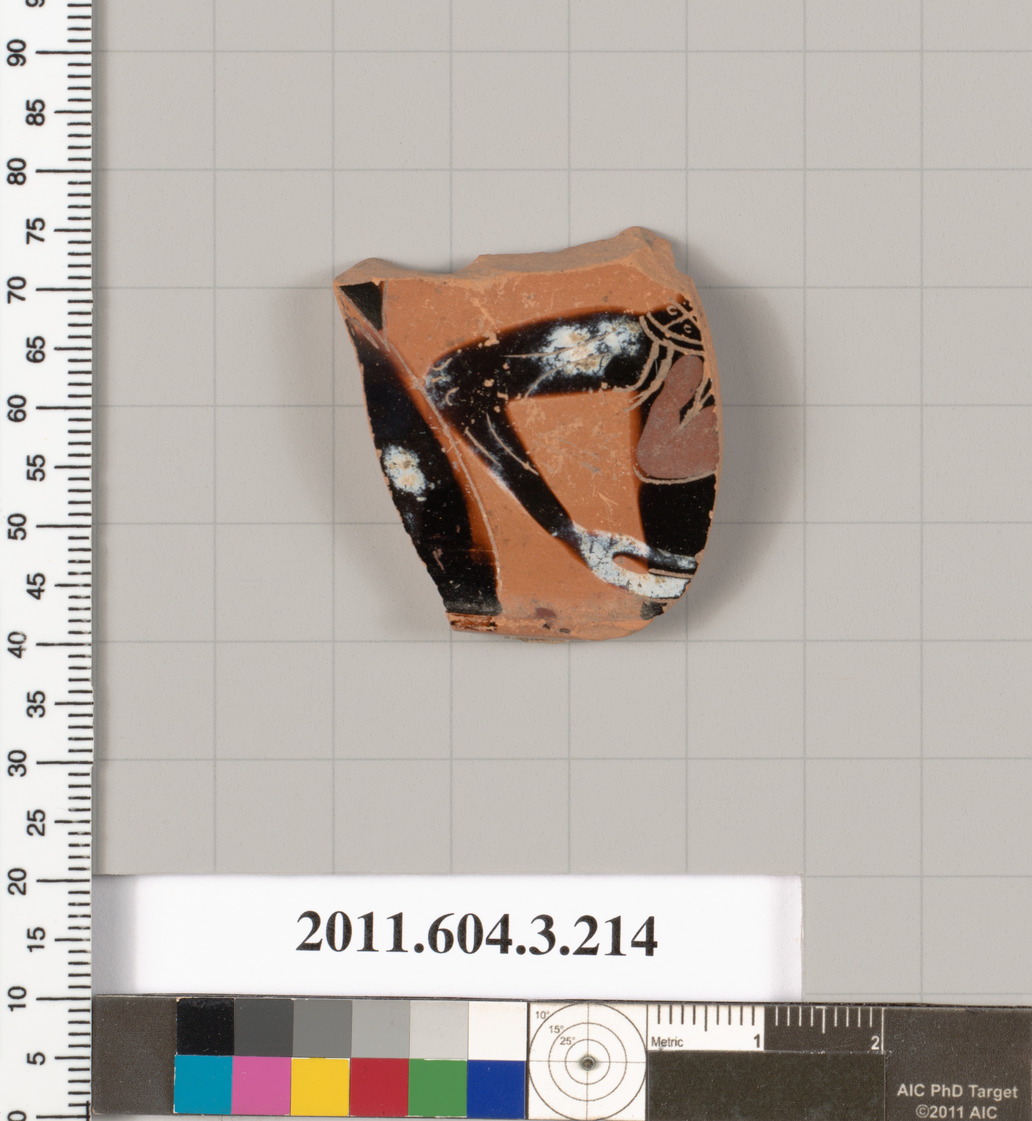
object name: neck amphora fragment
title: Terracotta fragment of a neck-amphora of Nicosthenic shape (jar)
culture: greek, attic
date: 525-501 BCE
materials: terracotta